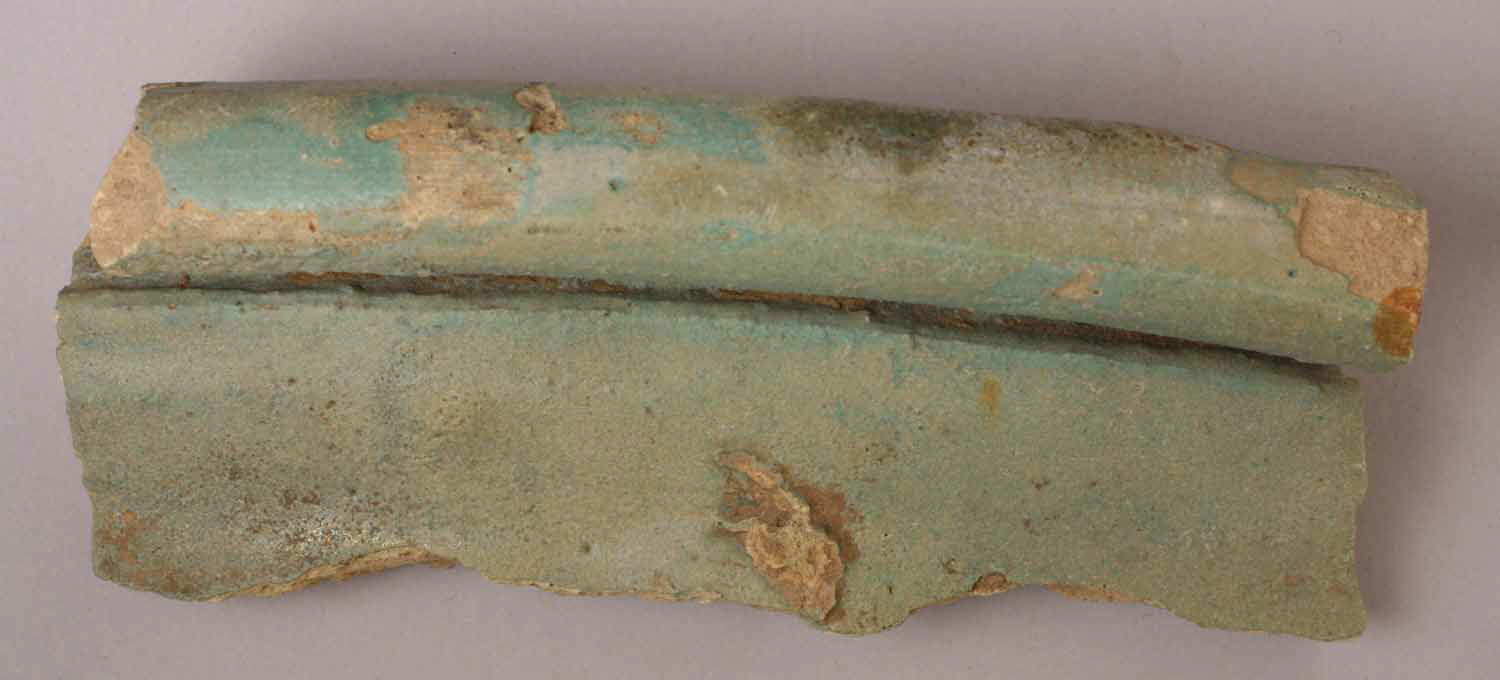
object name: fragment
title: Ceramic Fragment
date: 601-900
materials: earthenware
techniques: glazing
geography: iraq